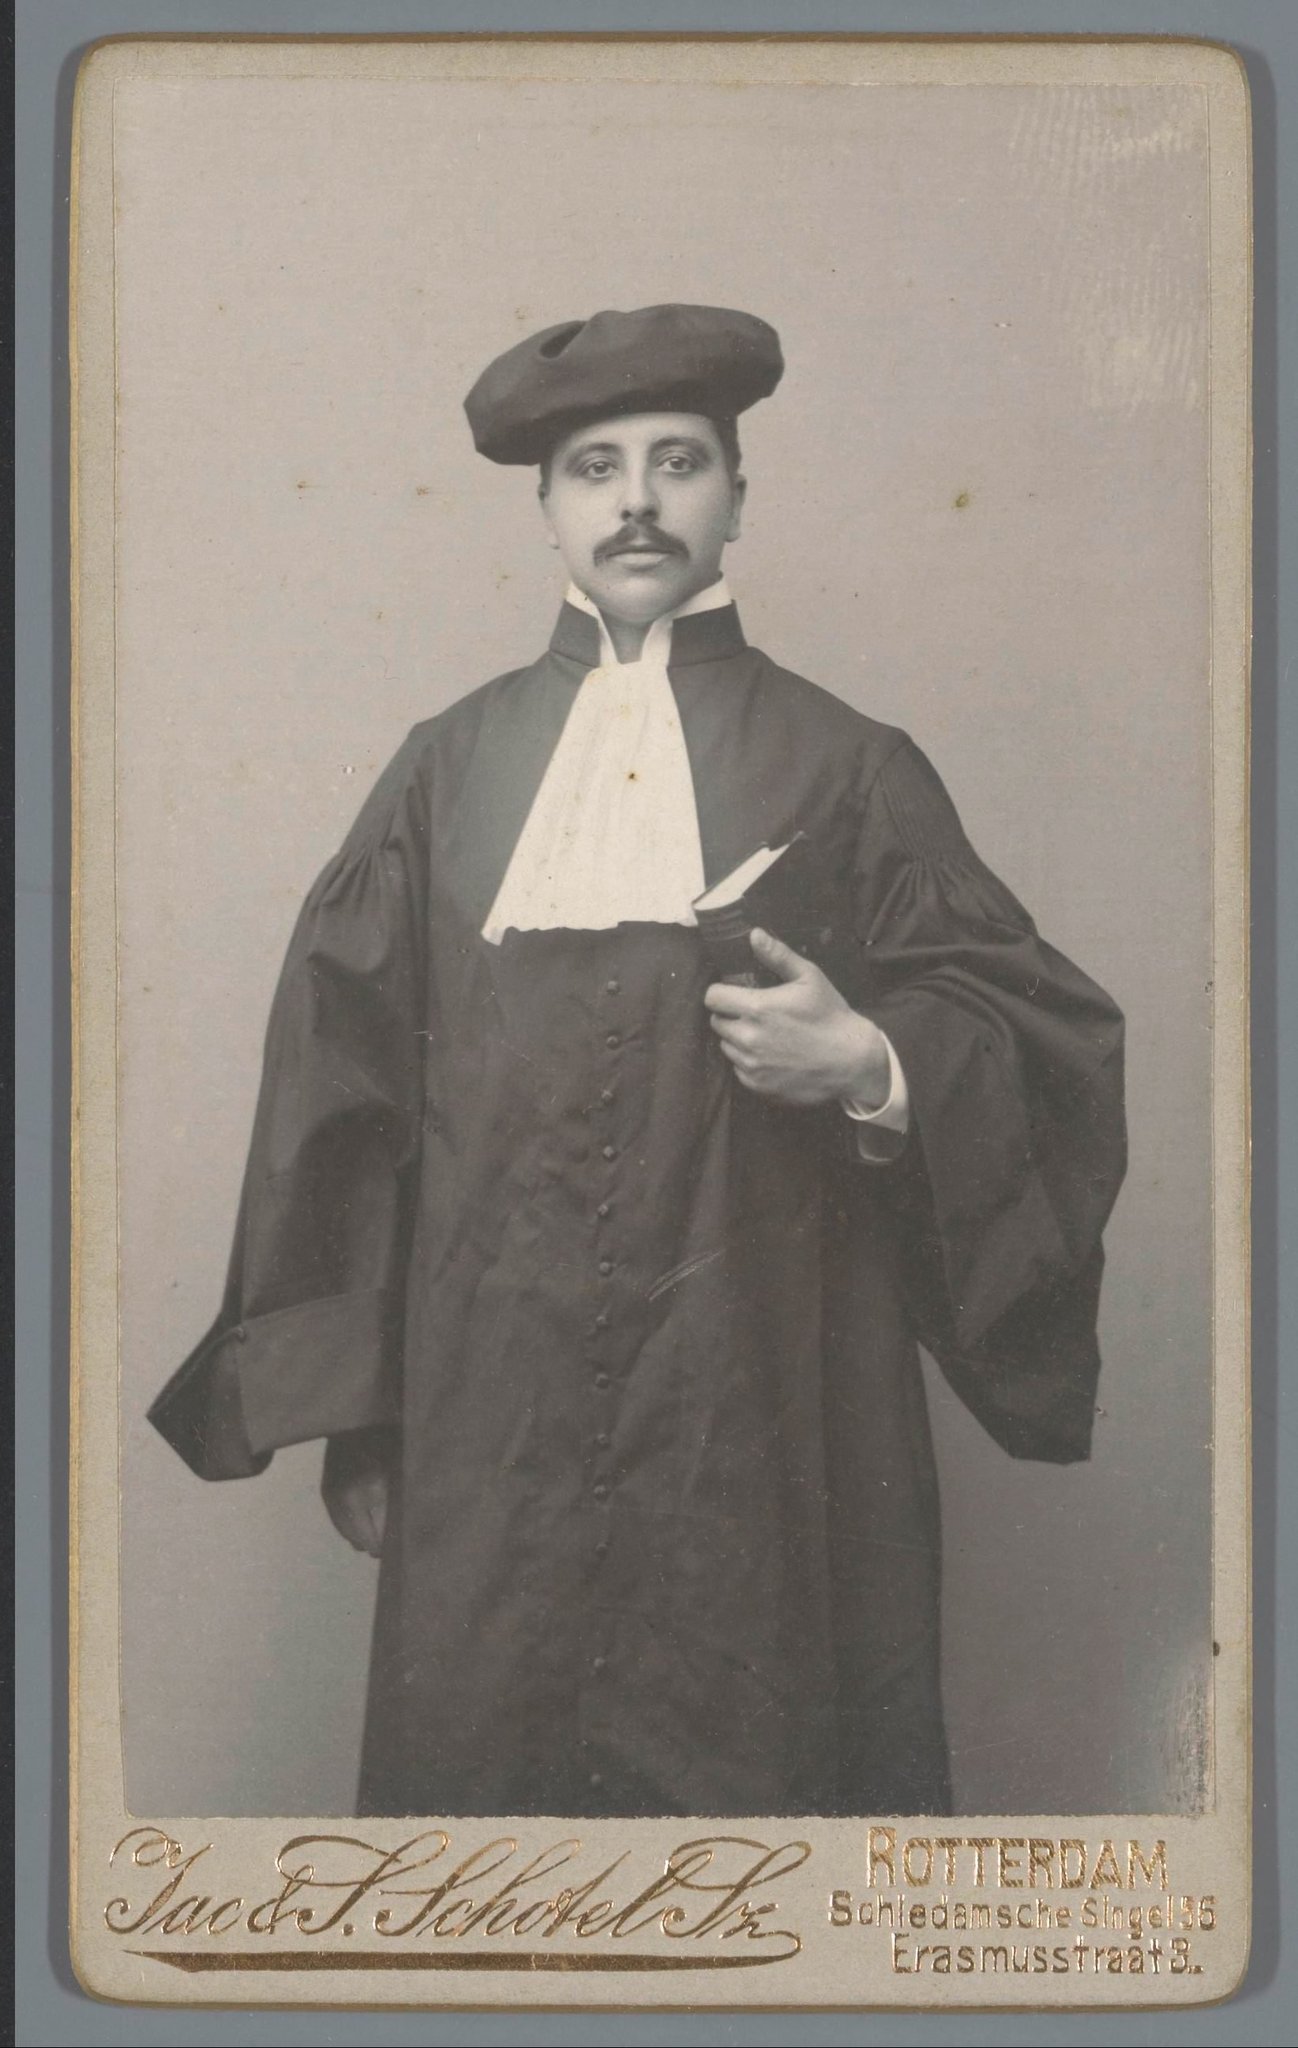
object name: carte de visite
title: Portret van een onbekende rechter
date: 1811-1899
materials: paper, cardboard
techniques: gelatin silver print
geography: rotterdam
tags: anonymous historical person portrayed, magistracy, judges, rotterdam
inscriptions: inscription: ‘Jac. & S. Schotel Sz Rotterdam/ Schiedamsche Singel 56/ Erasmusstraat 3.’, inscription: ‘Nov. 99,/ St. Nicolas’, number: ‘45- 55-’, inscription: ‘Jac. & S. Schotel Szn/ Ateliers voor Fotografie/ Schiedamsche Singel 56 & Erasmusstraat 3/ Rotterdam’